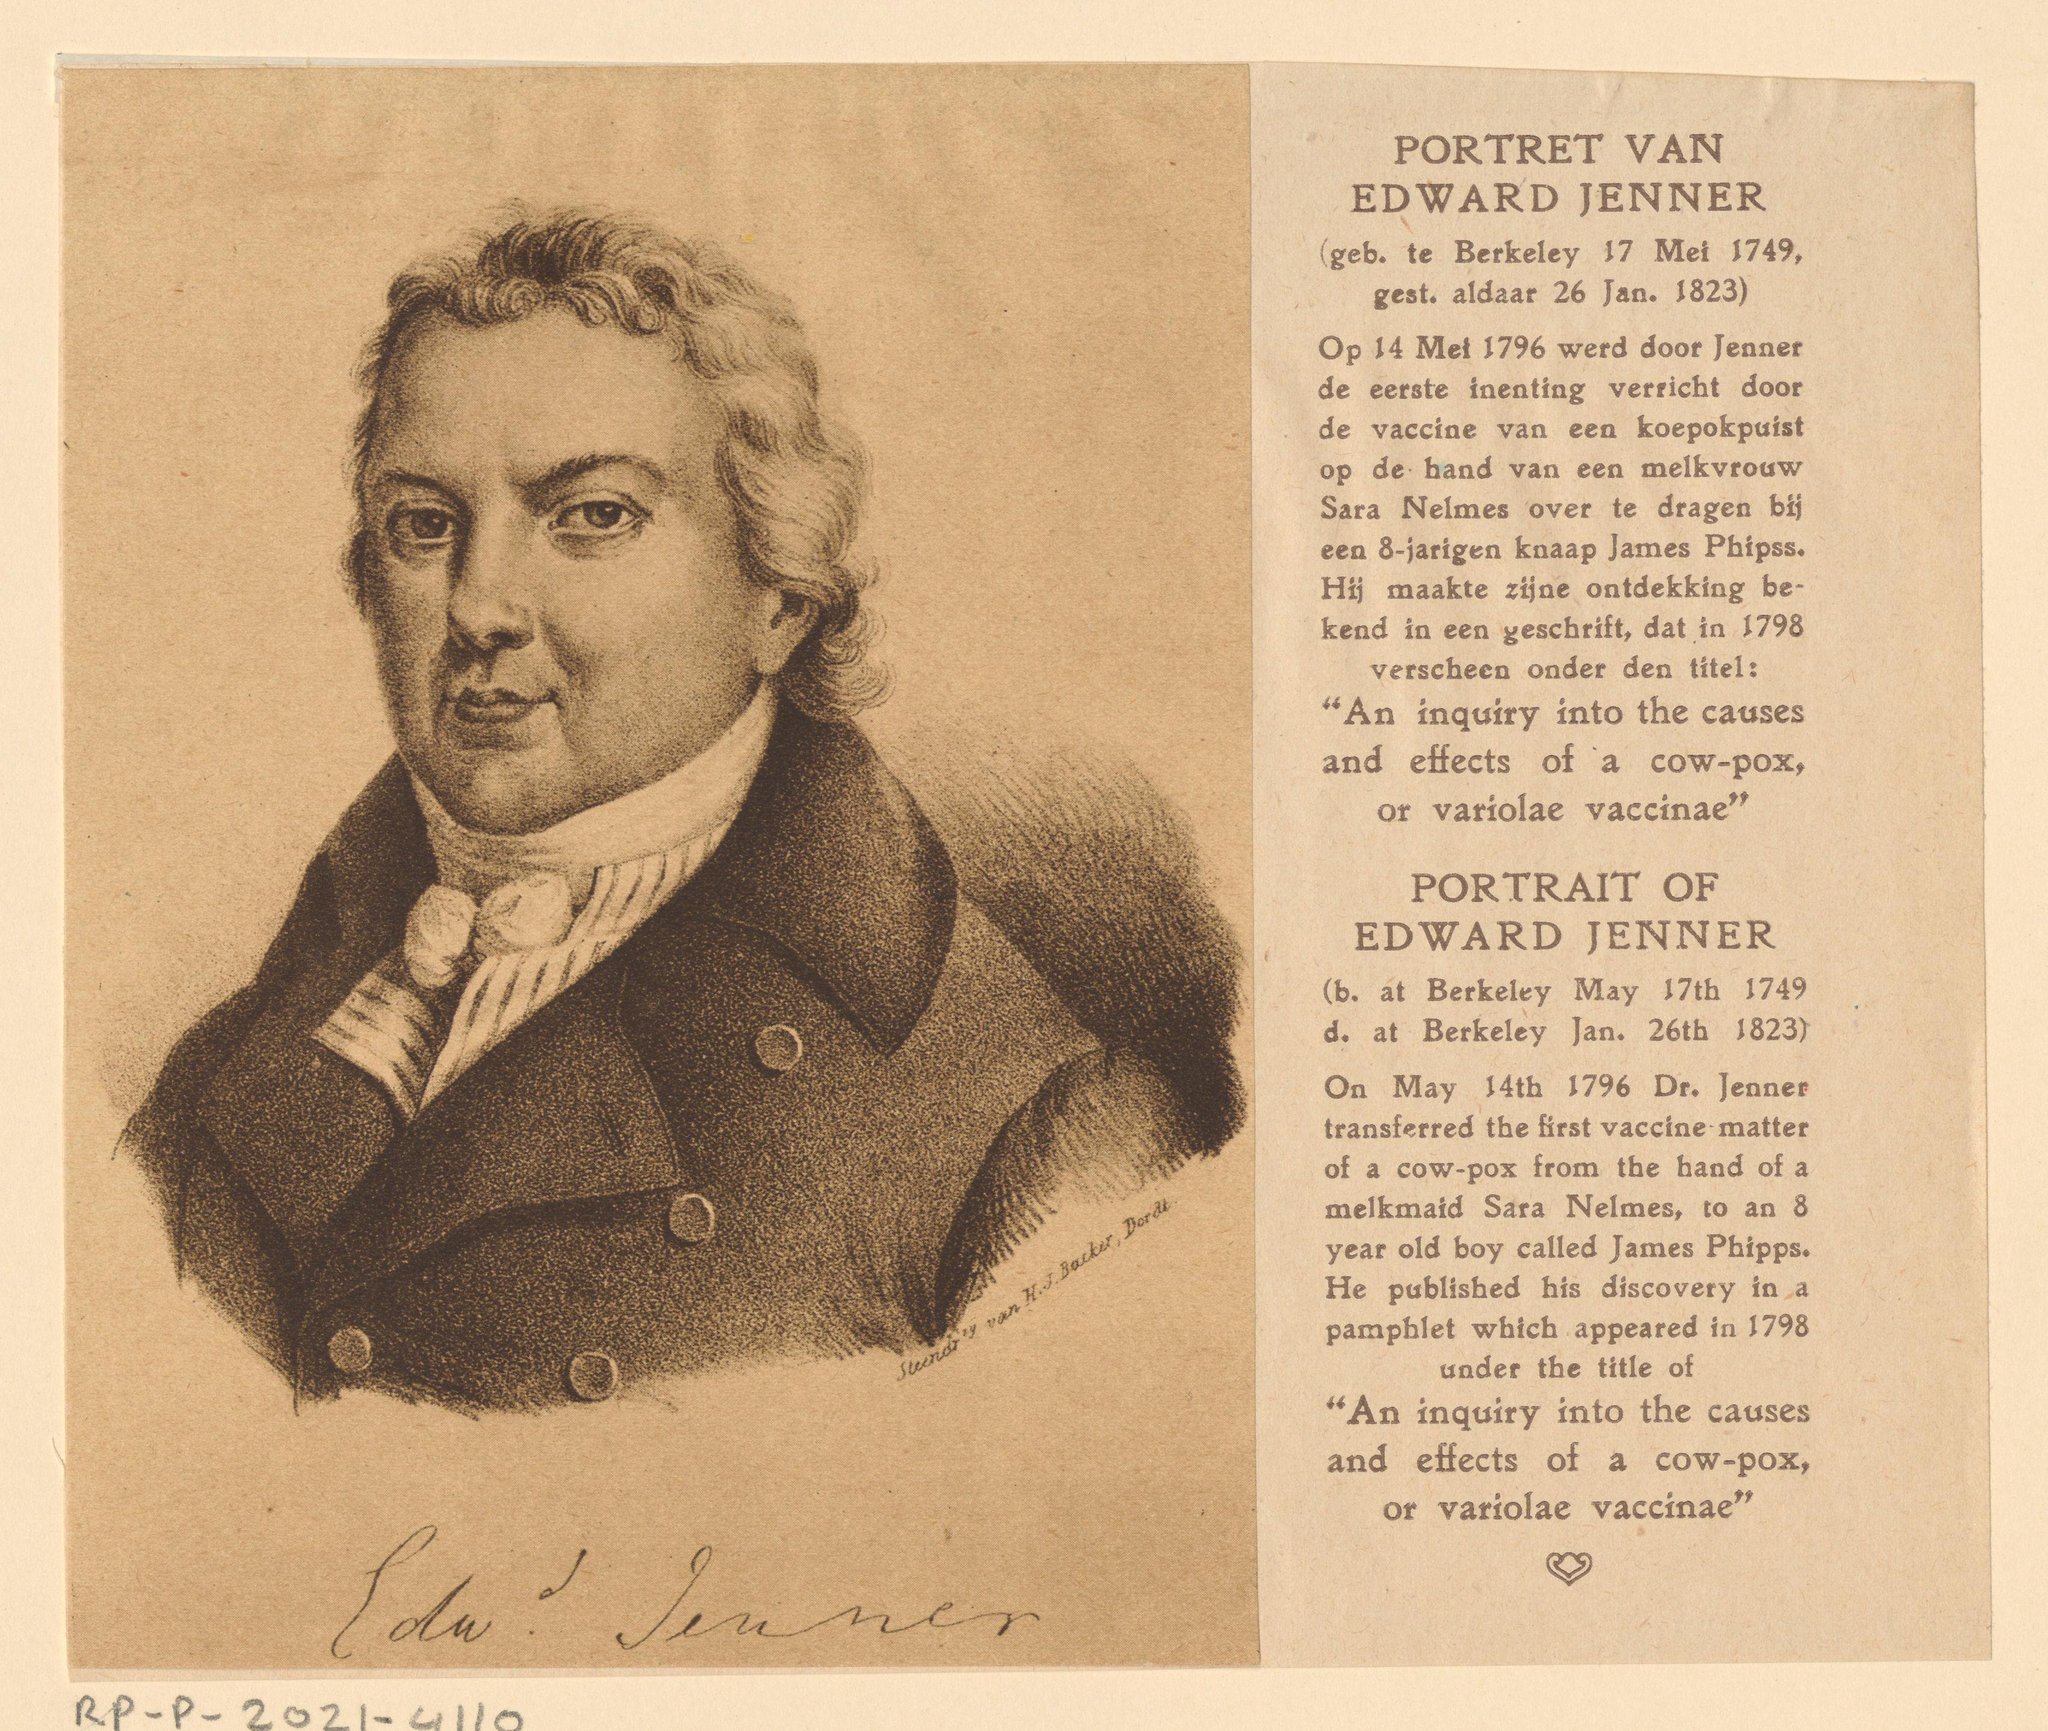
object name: photomechanical print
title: Portret van Edward Jenner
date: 1895-1950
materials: paper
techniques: letterpress printing, rotogravure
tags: historical persons, physician, doctor